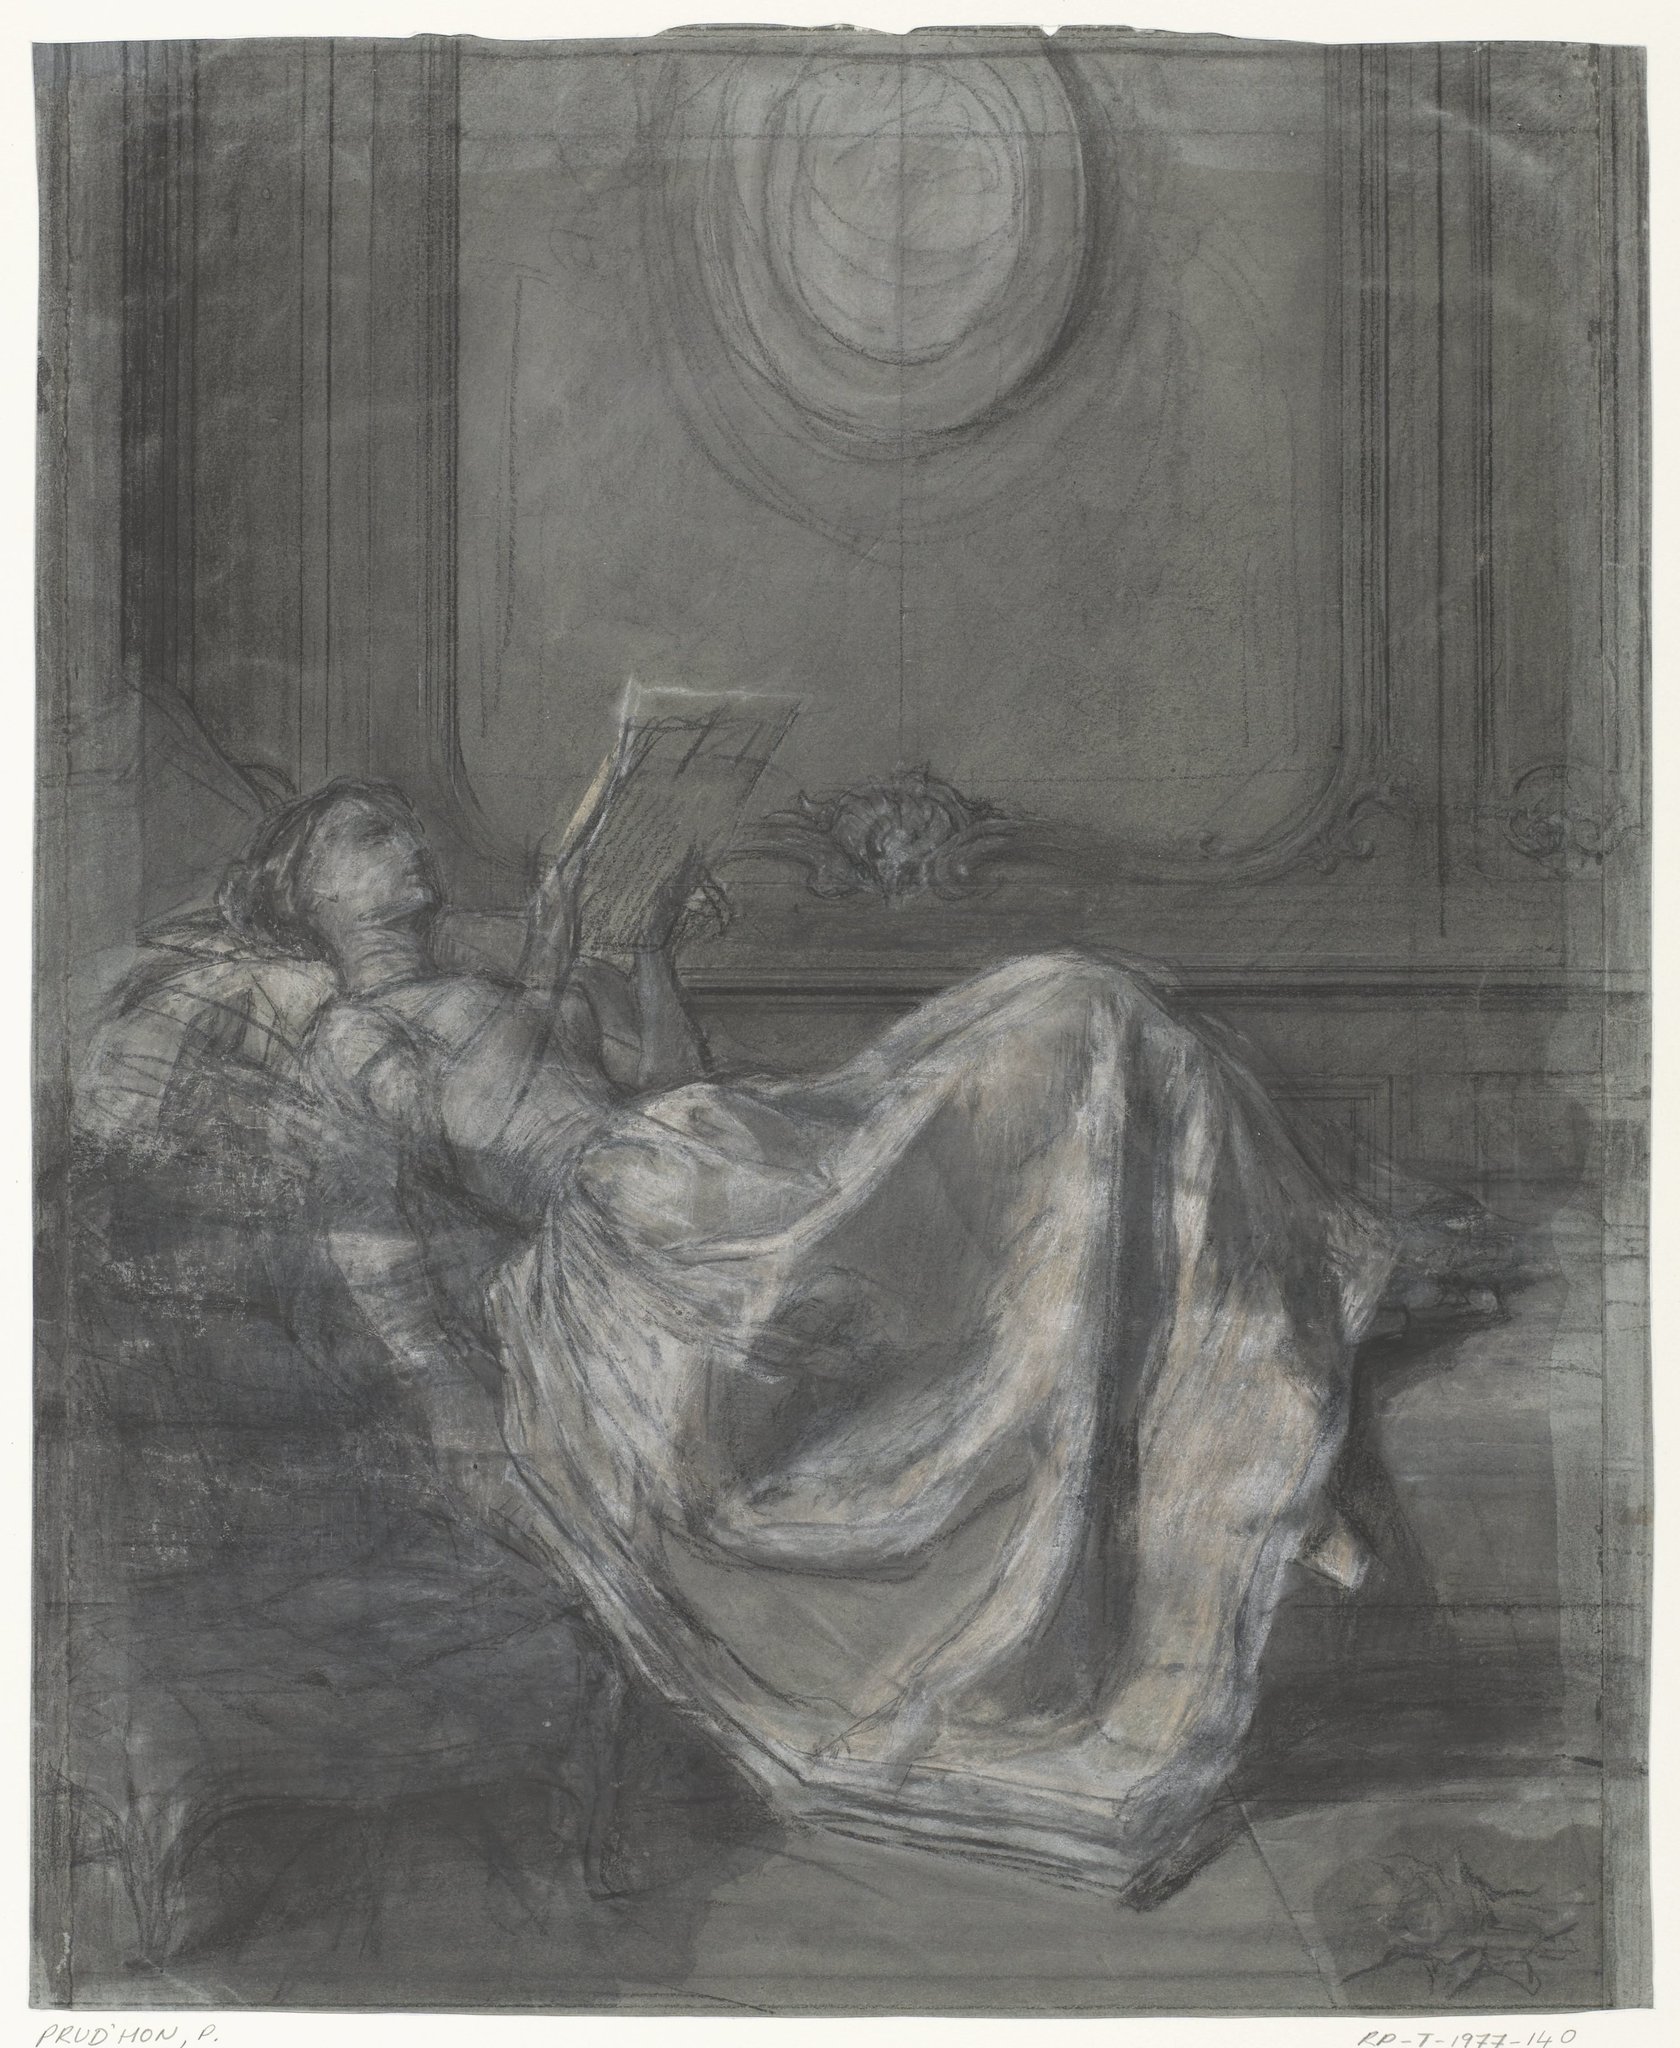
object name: drawing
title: Lezende vrouw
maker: pierre prudhon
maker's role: draughtsman, painter, print maker, publisher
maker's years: 1758-1823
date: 1768-1823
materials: chalk, paper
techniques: brush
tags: reading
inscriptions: collector's mark, verso, lower centre: Lugt 2228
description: Een lezende vrouw, liggend op een bank in een interieur.